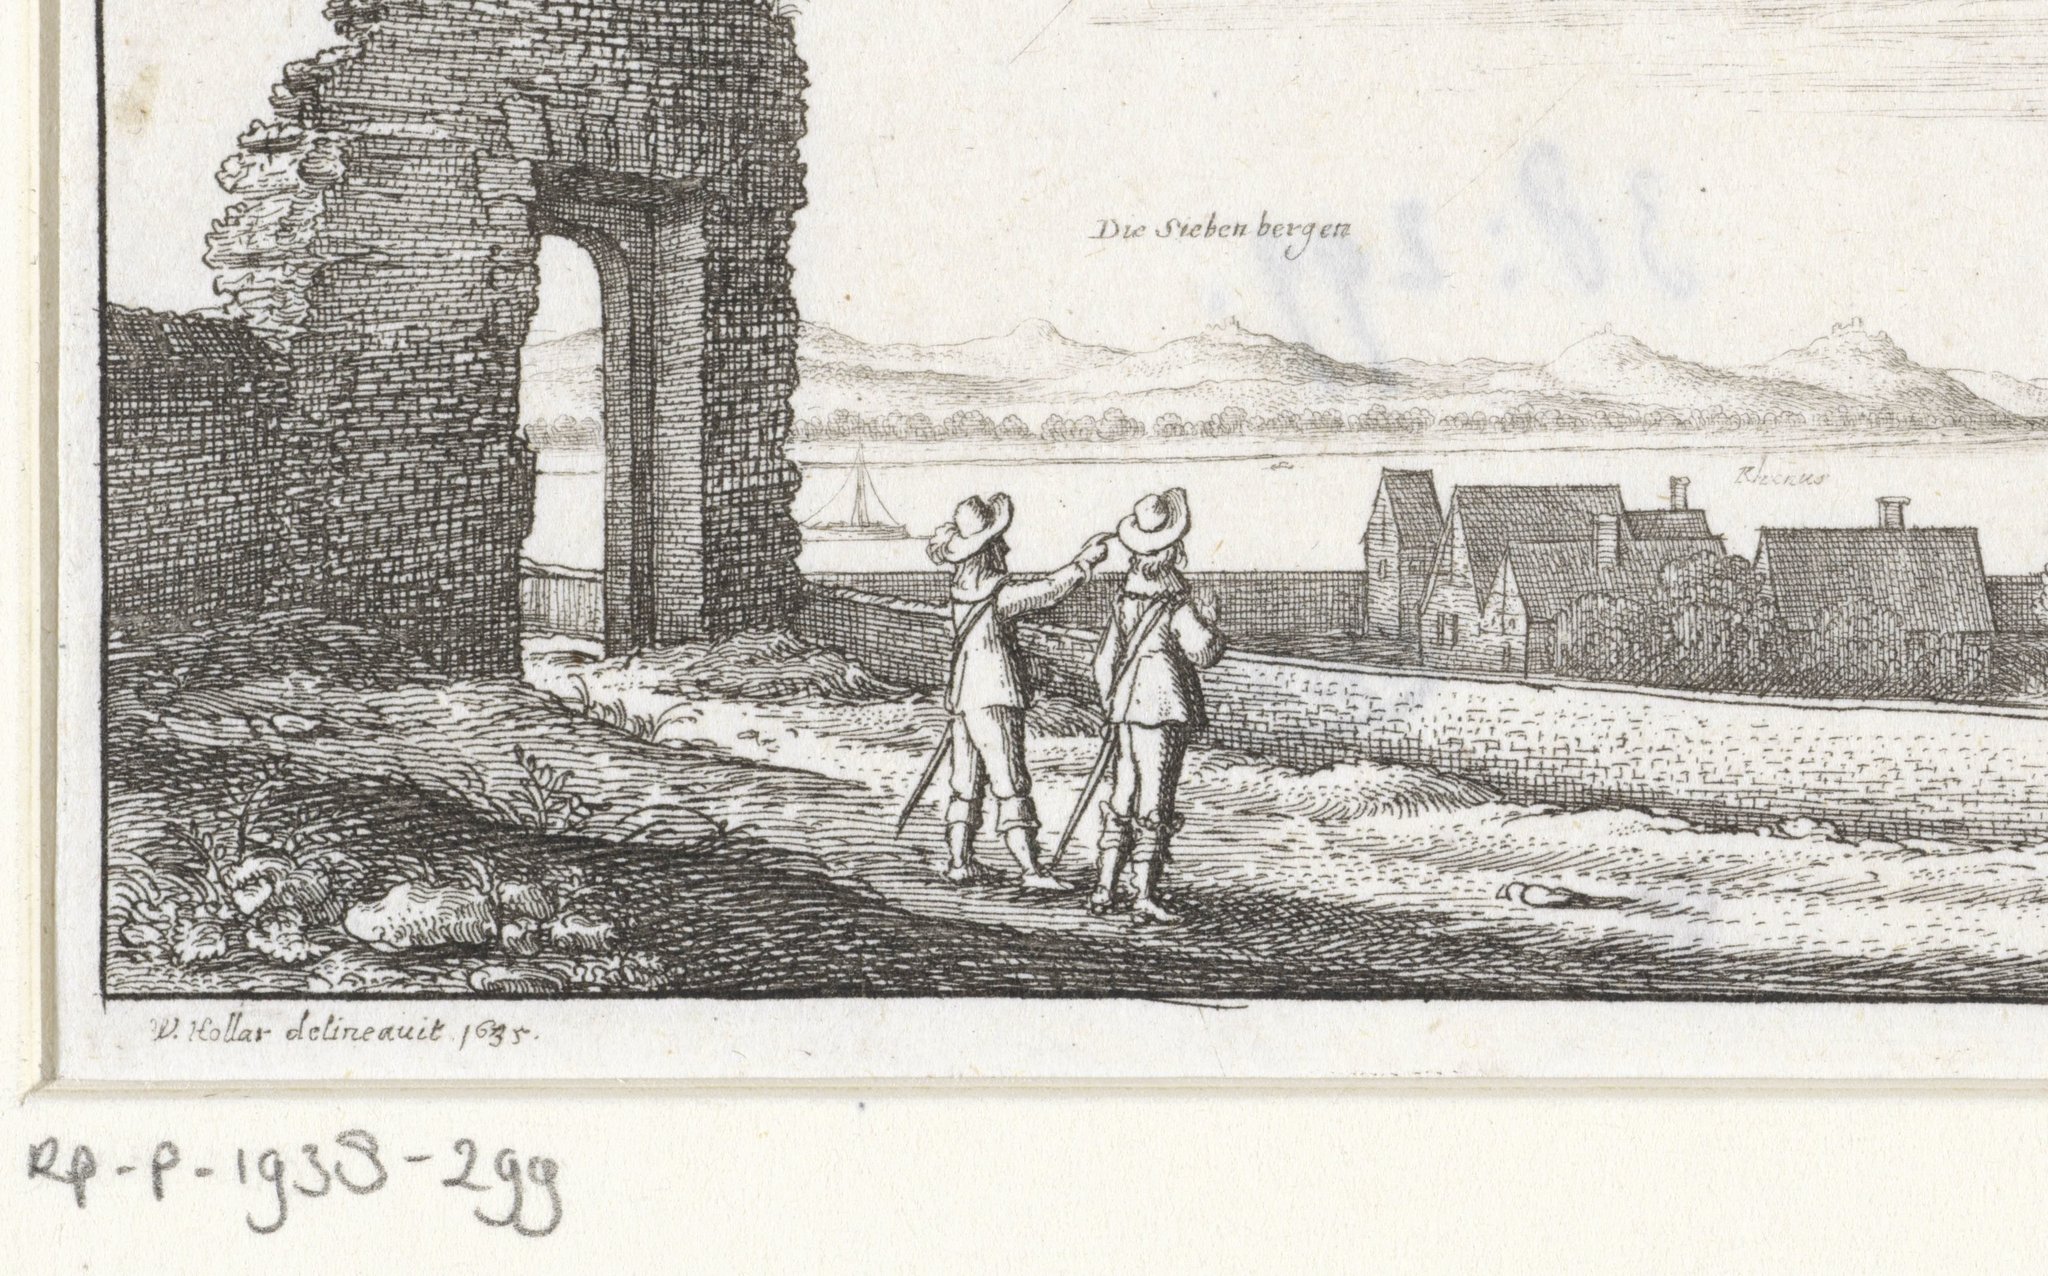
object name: print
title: Prospectus Aliquot Locorum In Diversis Provincys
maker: wenceslaus hollar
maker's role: draughtsman, print maker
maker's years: 1607-1677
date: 1635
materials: paper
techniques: etching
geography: london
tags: city-view, and landscape with man-made constructions, mountains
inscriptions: collector's mark: Lugt 2228, collector's mark: Lugt 2760